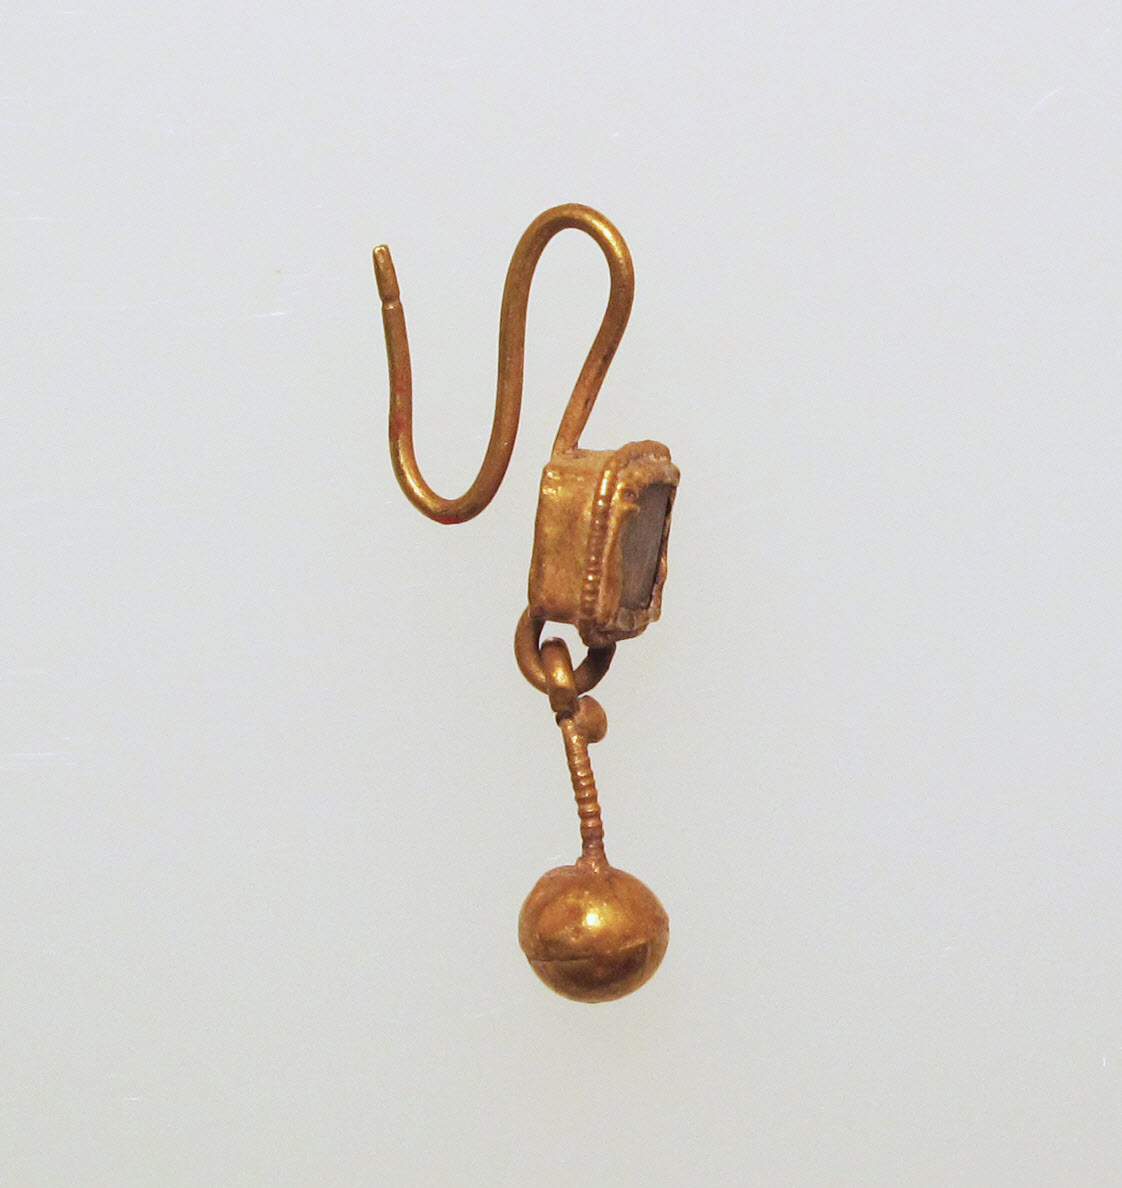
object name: earring hook type with pendant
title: Earring-hook type with pendant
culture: roman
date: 101-200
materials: gold